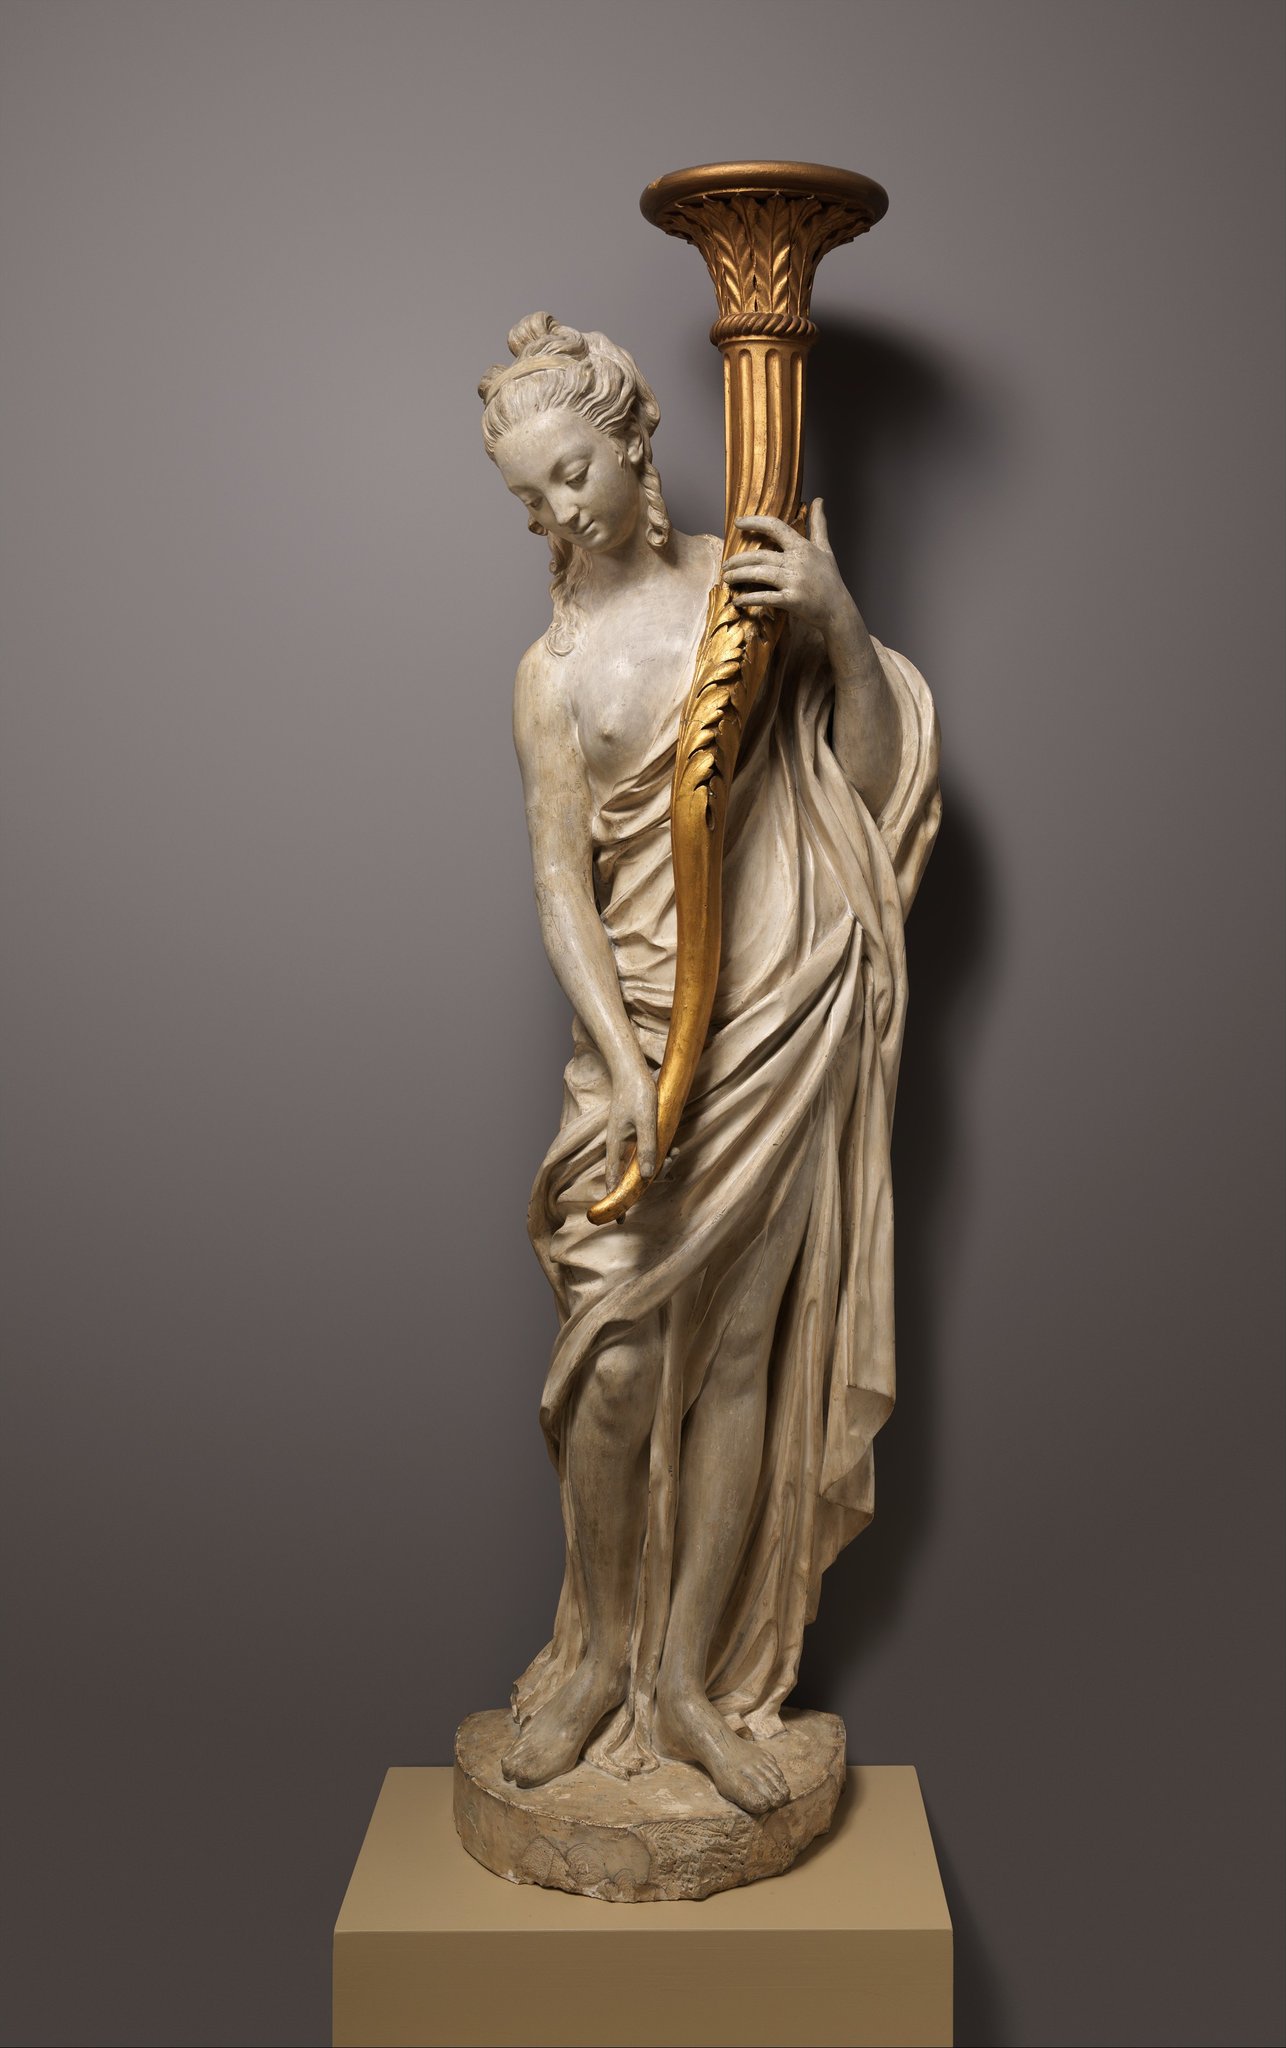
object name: torchère figure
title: Torchère figure (one of a pair)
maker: augustin pajou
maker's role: artist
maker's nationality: french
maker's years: 1730-1809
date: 1801-1900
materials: plaster, wood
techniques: carving, gilding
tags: nymphs